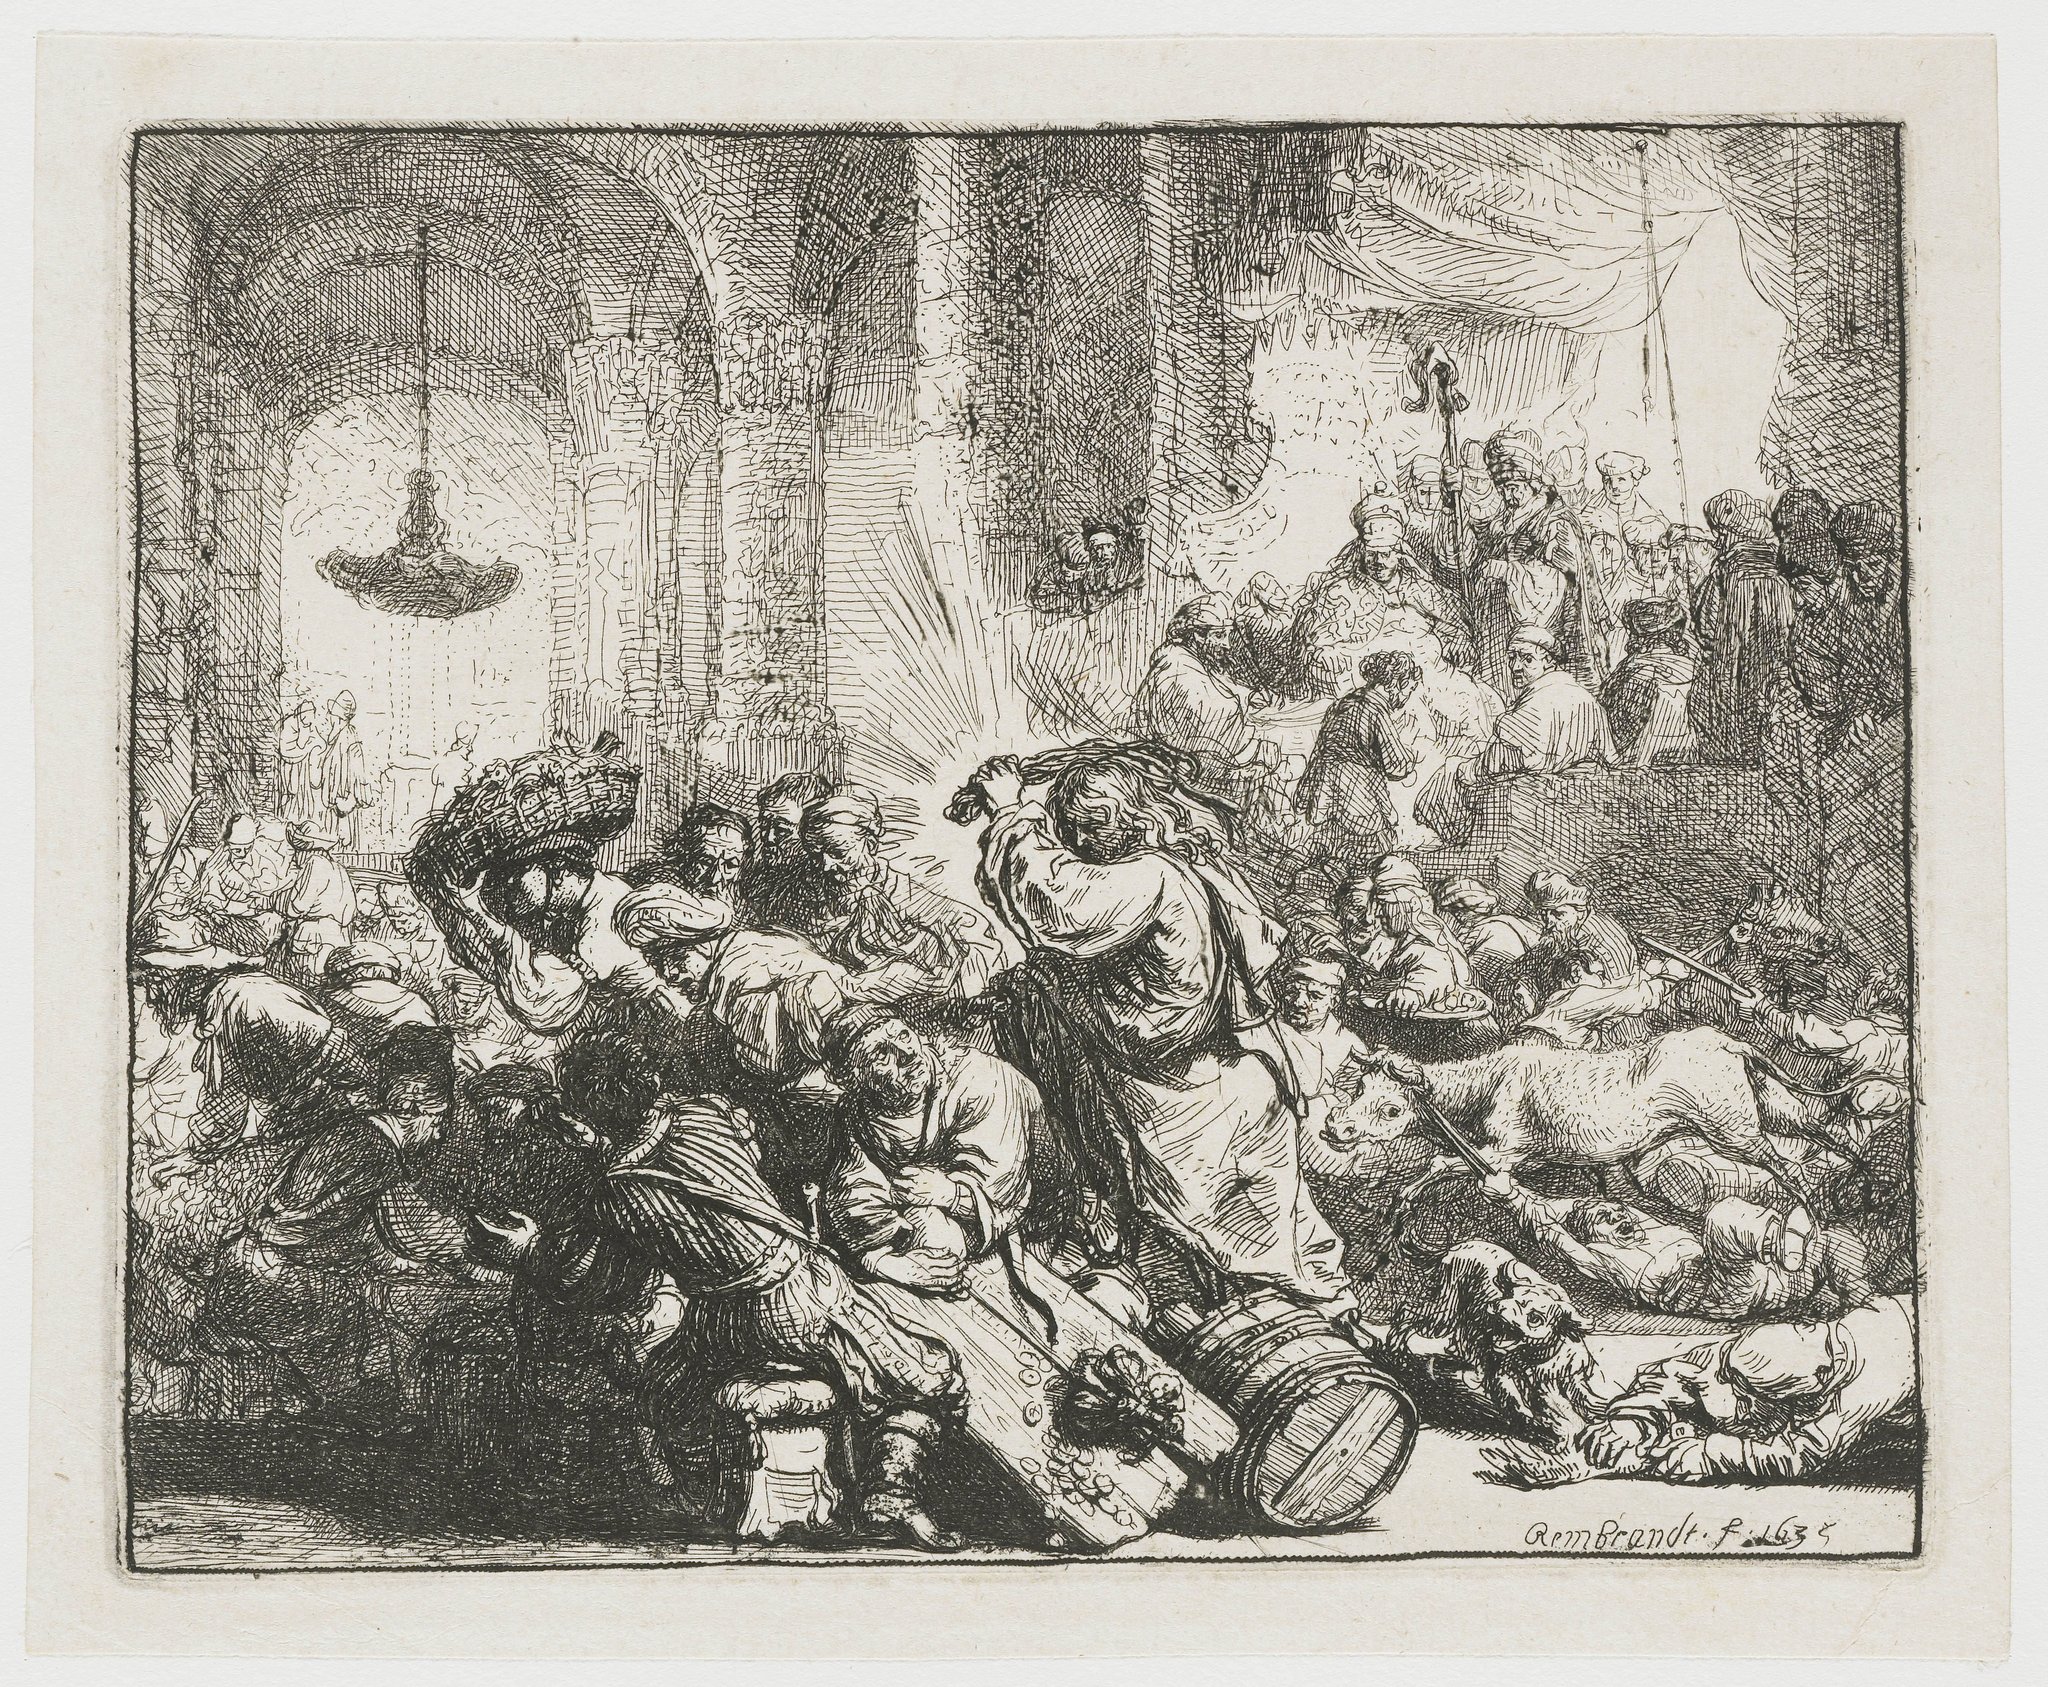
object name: print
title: Christ driving the money changers from the temple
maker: rembrandt van rijn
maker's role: draughtsman, painter, print maker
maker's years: 1606-1669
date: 1635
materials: paper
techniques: etching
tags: purification of the temple ('first' and 'second'): christ driving the money-changers from the temple with a whip (matthew 21:12-13; mark 11:15-17; luke 19:45-46; john 12:12-19)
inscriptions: collector's mark: Lugt 2228, collector's mark: Lugt 654, signature and date: ‘Rembrandt f. 1635’, collector's mark: Lugt 533 b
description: With a theatrical sense of drama, Rembrandt captures Christ cleansing the Temple with a whip he made of cords. An ox running amuck drags its owner along, and a woman selling a basket of doves takes to her heels. The money-changers must bear the brunt: Christ overturns their table. This is indeed how it is described in the Bible.